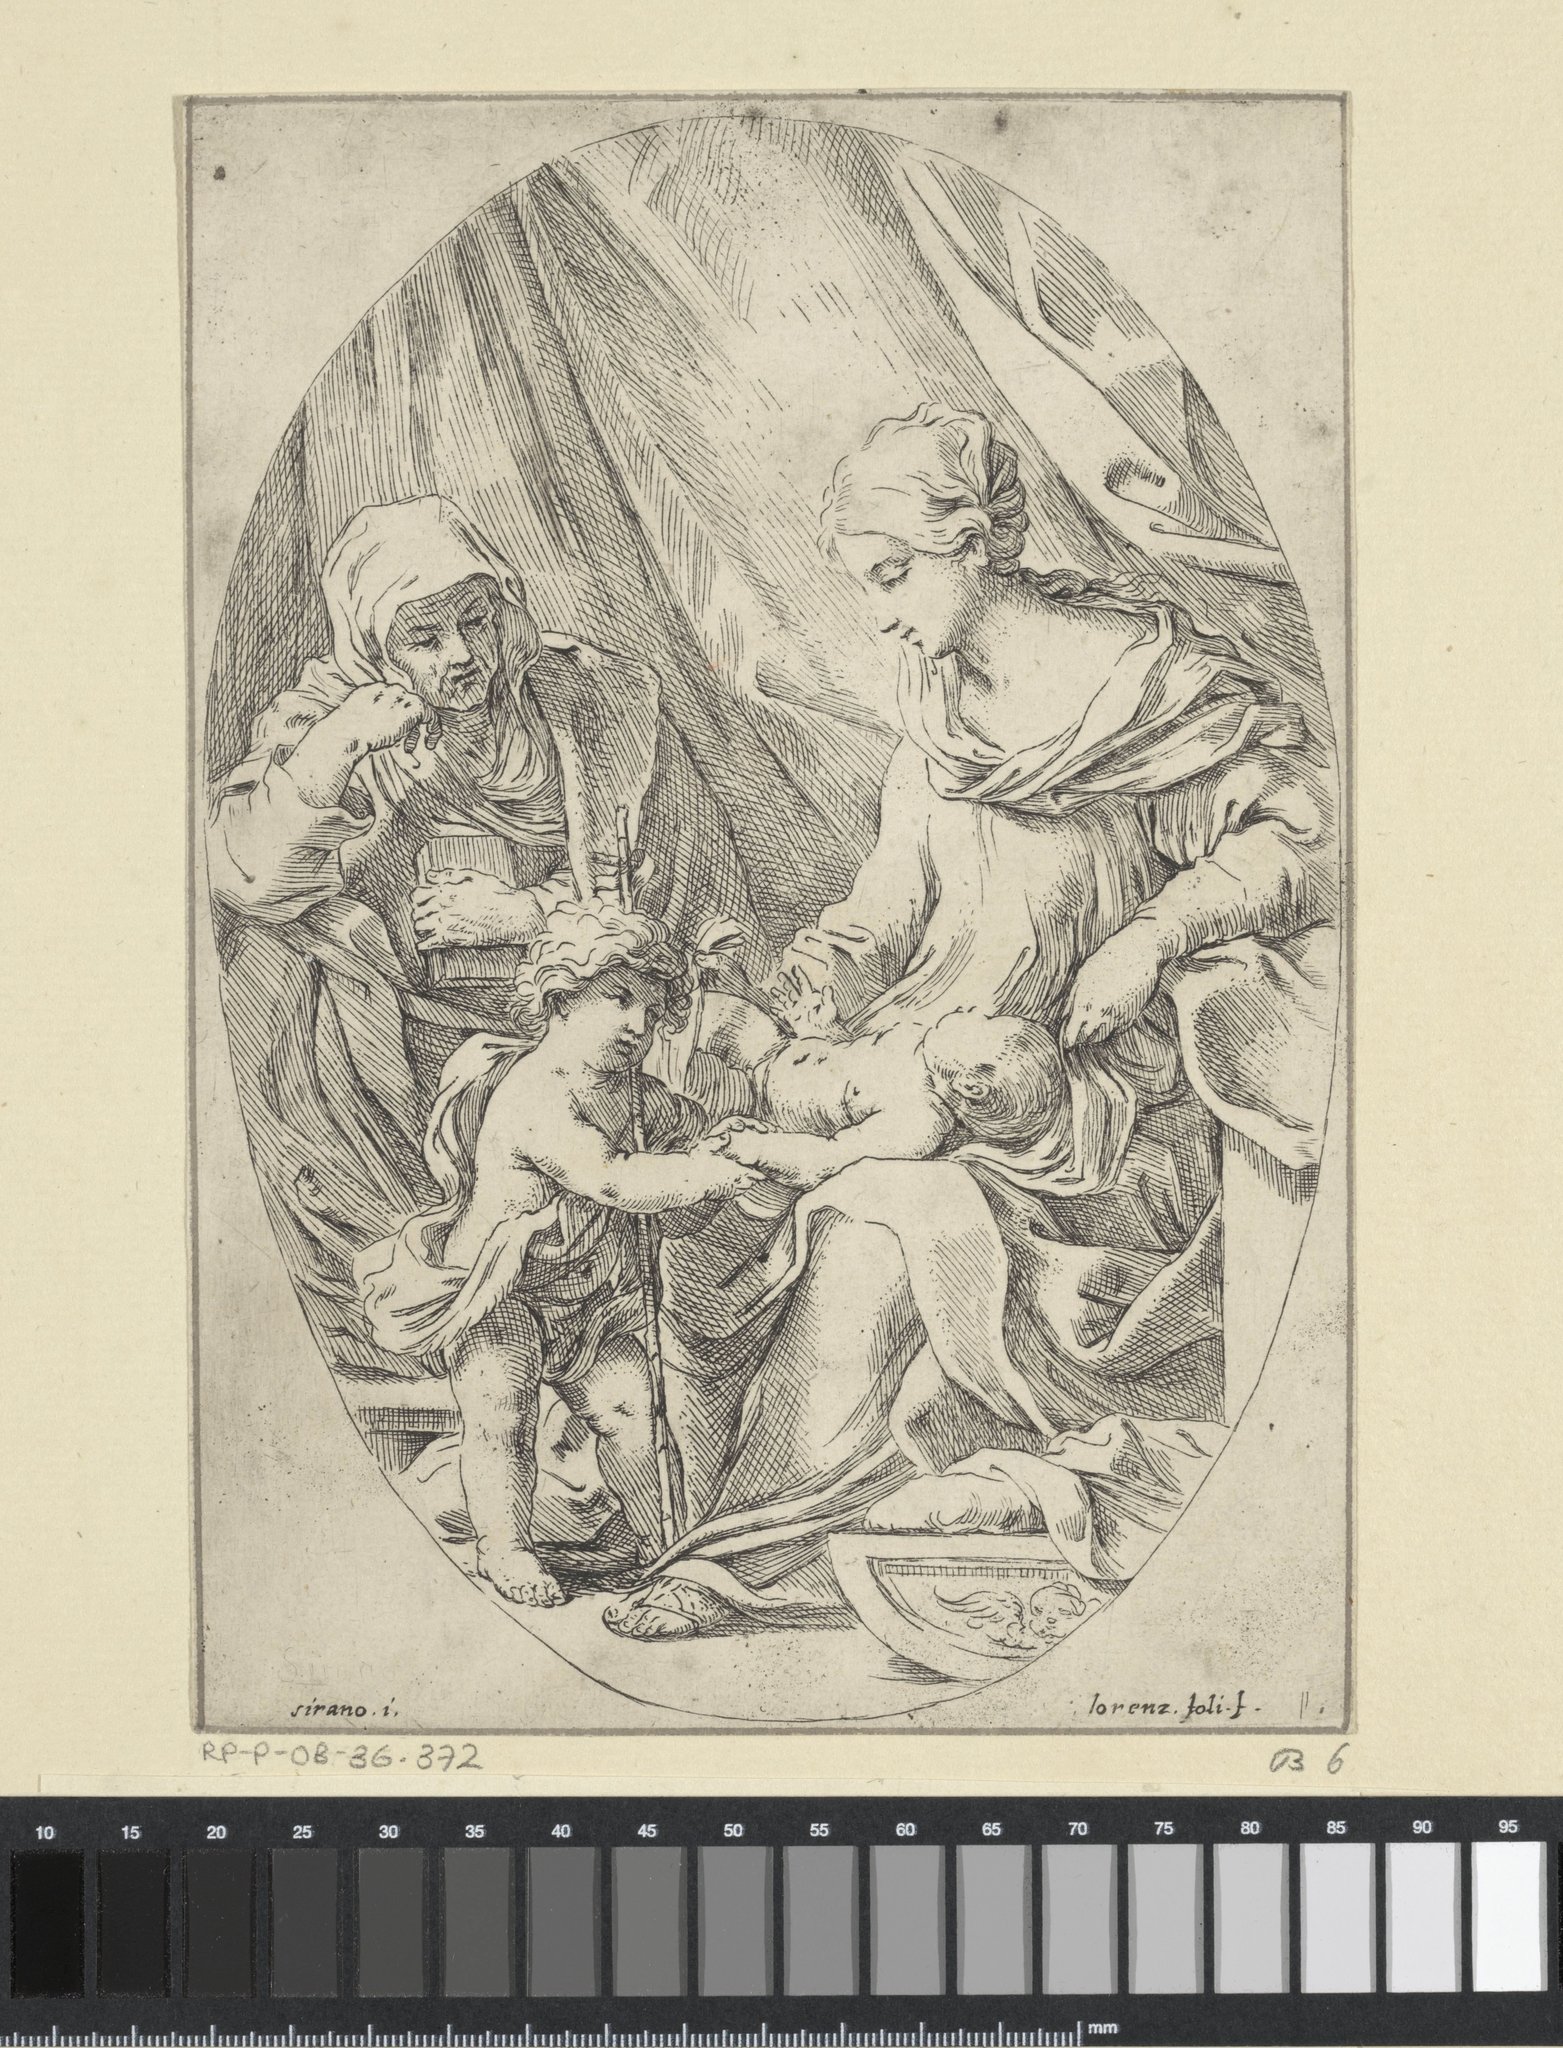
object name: print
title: Maria met het Christuskind, de jonge Johannes de Doper en Elisabet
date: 1622-1691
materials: paper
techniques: etching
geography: italy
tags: mary, the christ-child and john the baptist, elisabeth present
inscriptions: collector's mark: Lugt 240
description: Maria zit met het Christuskind op schoot. De jonge Johannes de Doper houdt de hand van Christus vast. Op de achtergrond zit Elisabet.